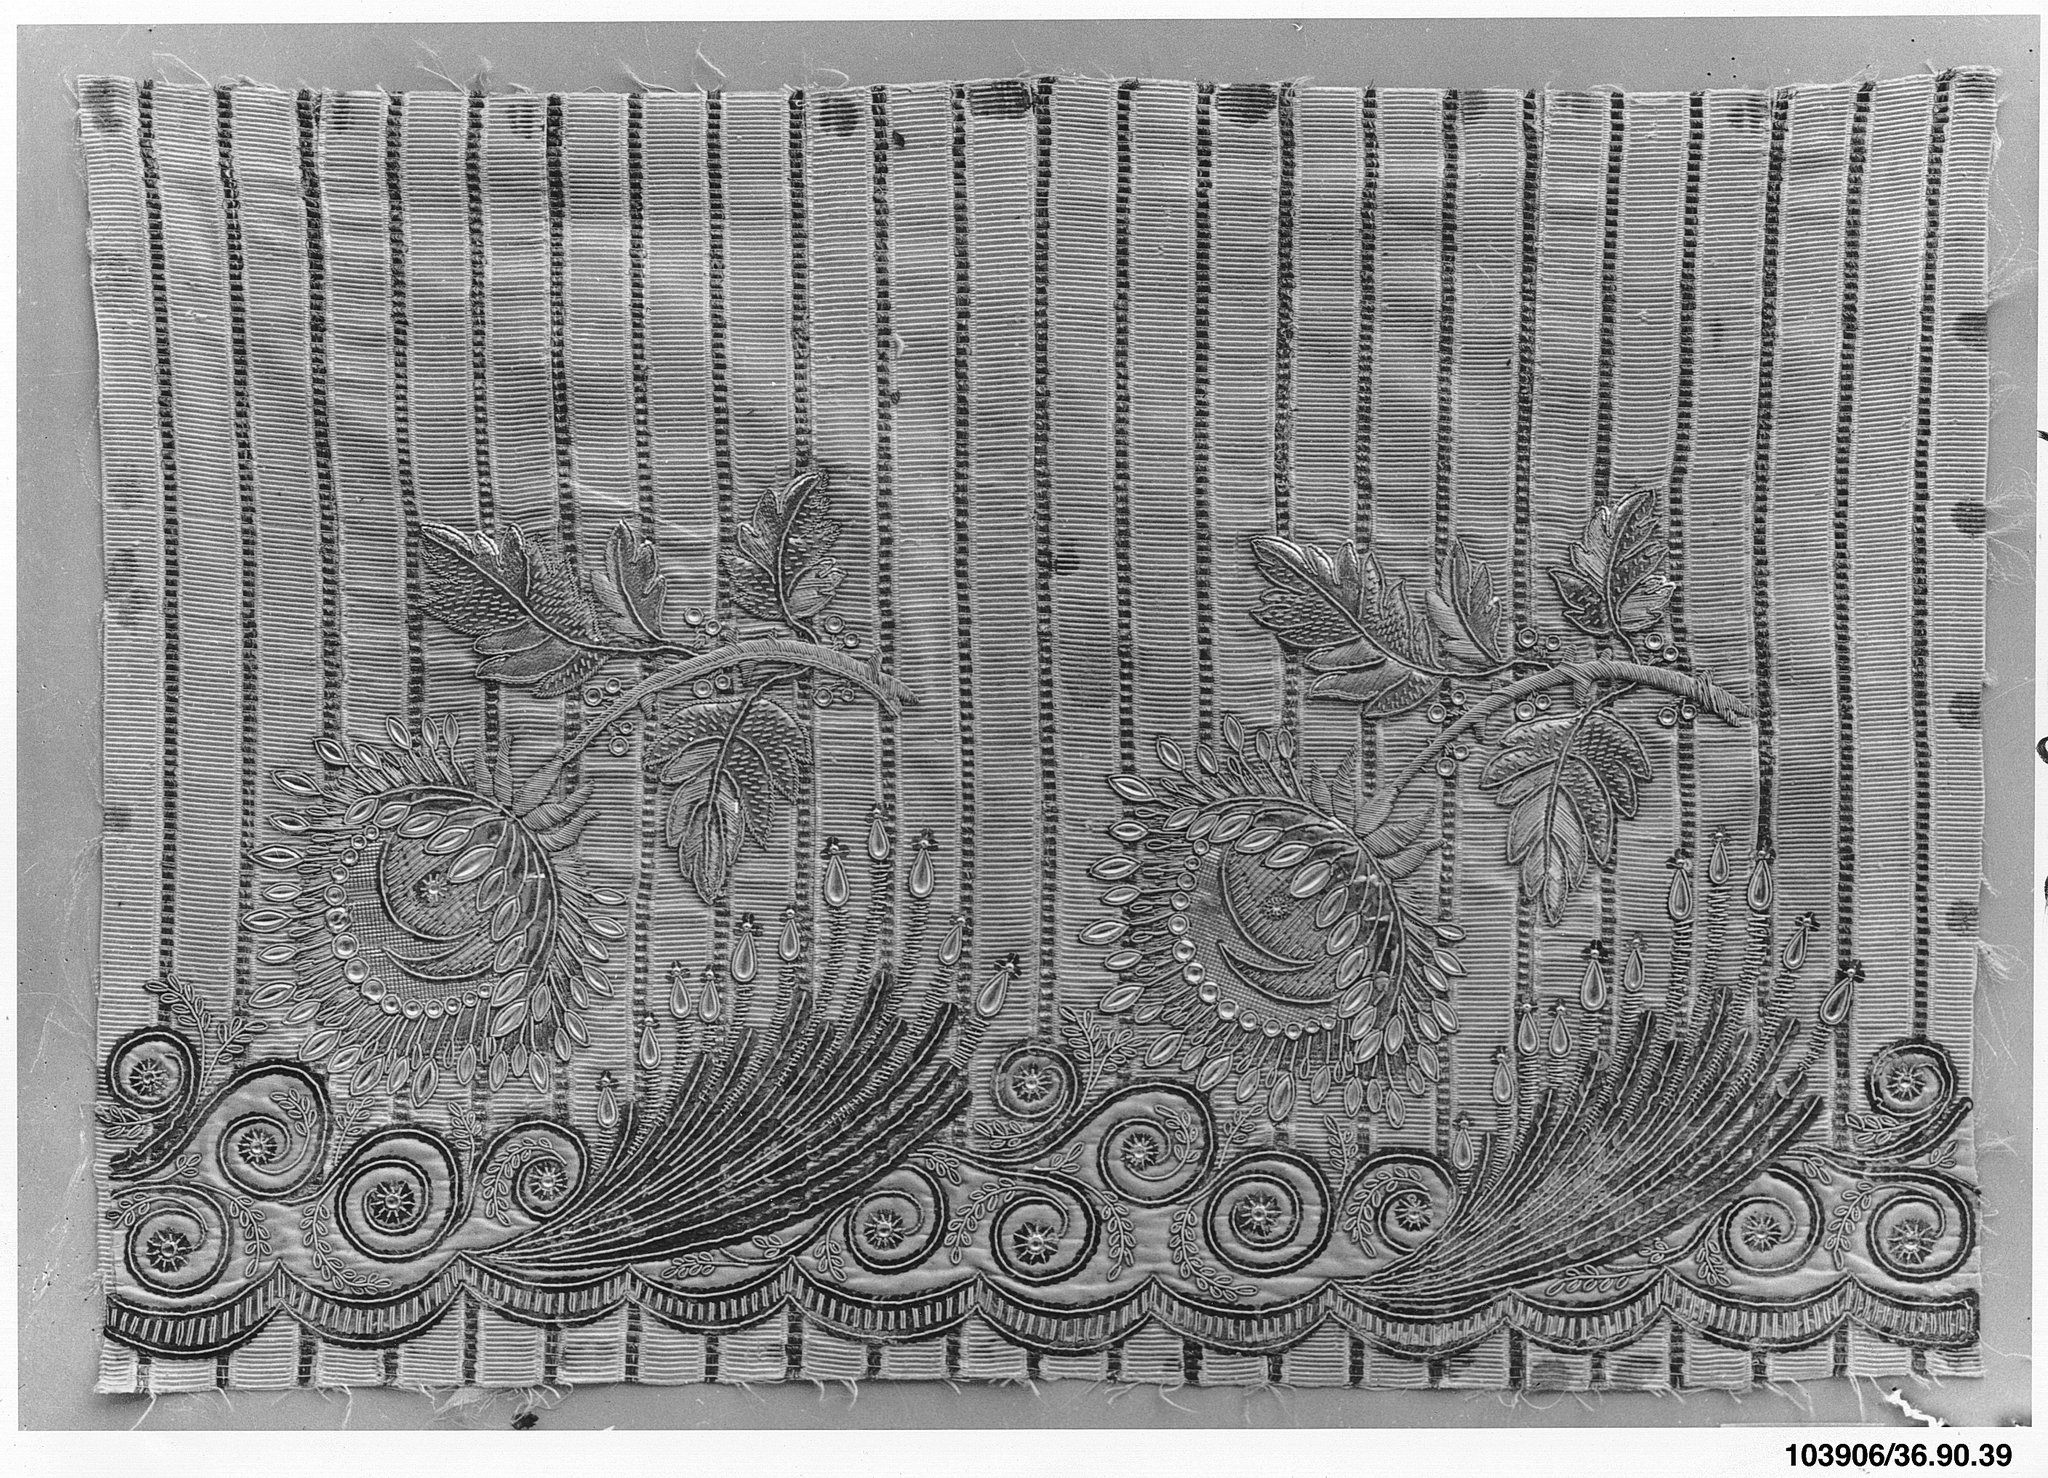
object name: border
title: Dress border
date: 1805-1815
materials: metal thread, silk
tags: flowers